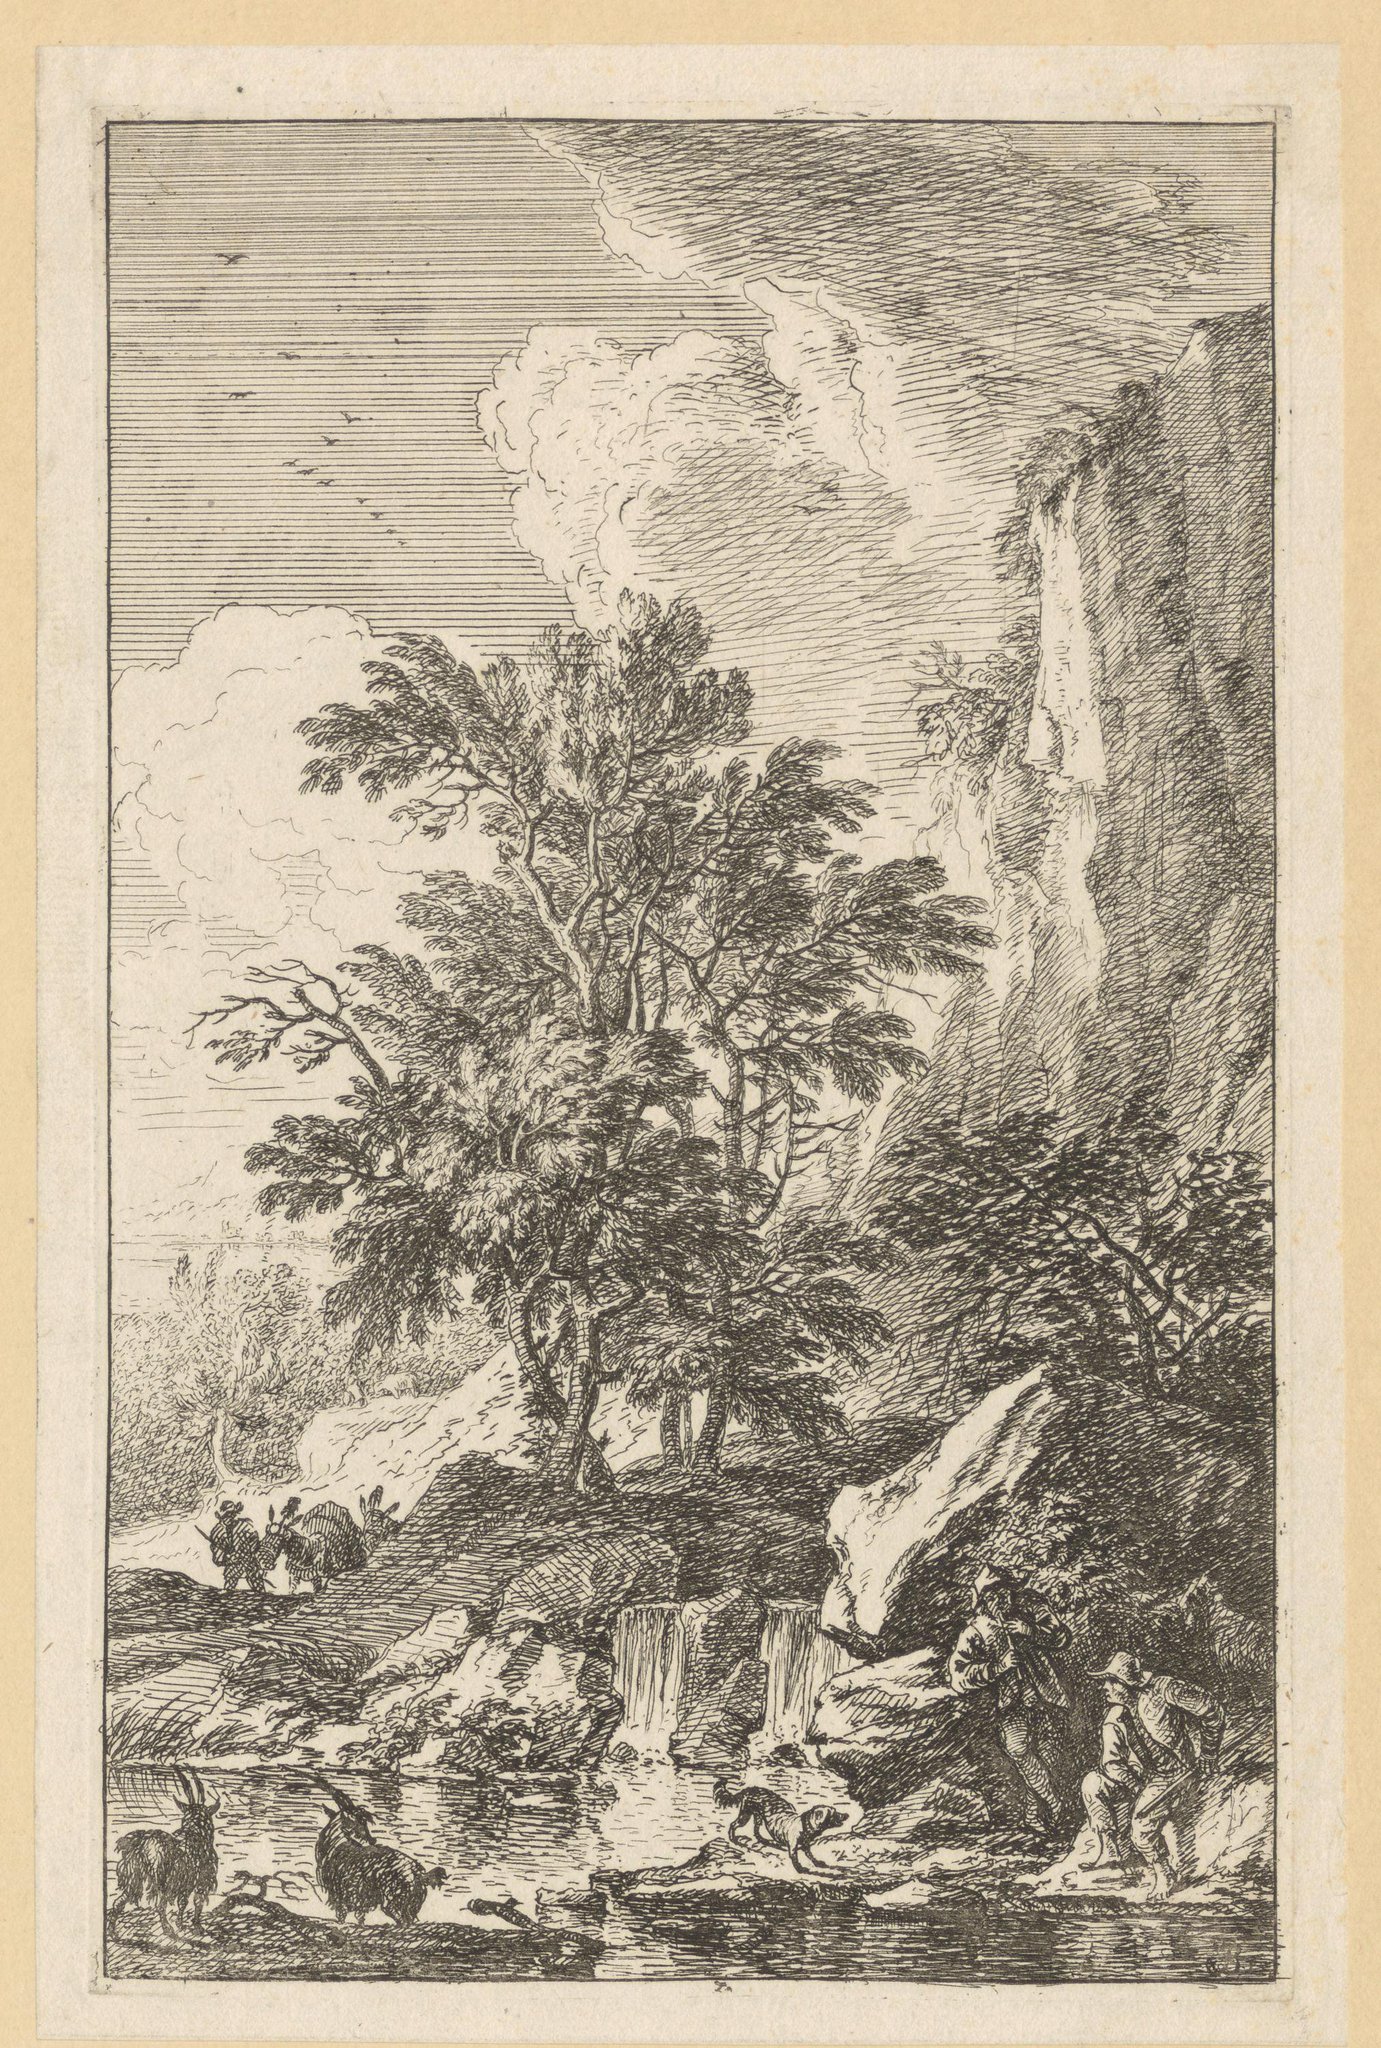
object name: print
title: Rotsachtig landschap met links twee geiten en rechts twee mannen met een hond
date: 1714-1724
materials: paper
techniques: etching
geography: augsburg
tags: landscapes, goat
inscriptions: collector's mark: Lugt 240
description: Derde prent uit de serie 'Landschappen in de stijl van Salvator Rosa', bestaand uit zes prenten.